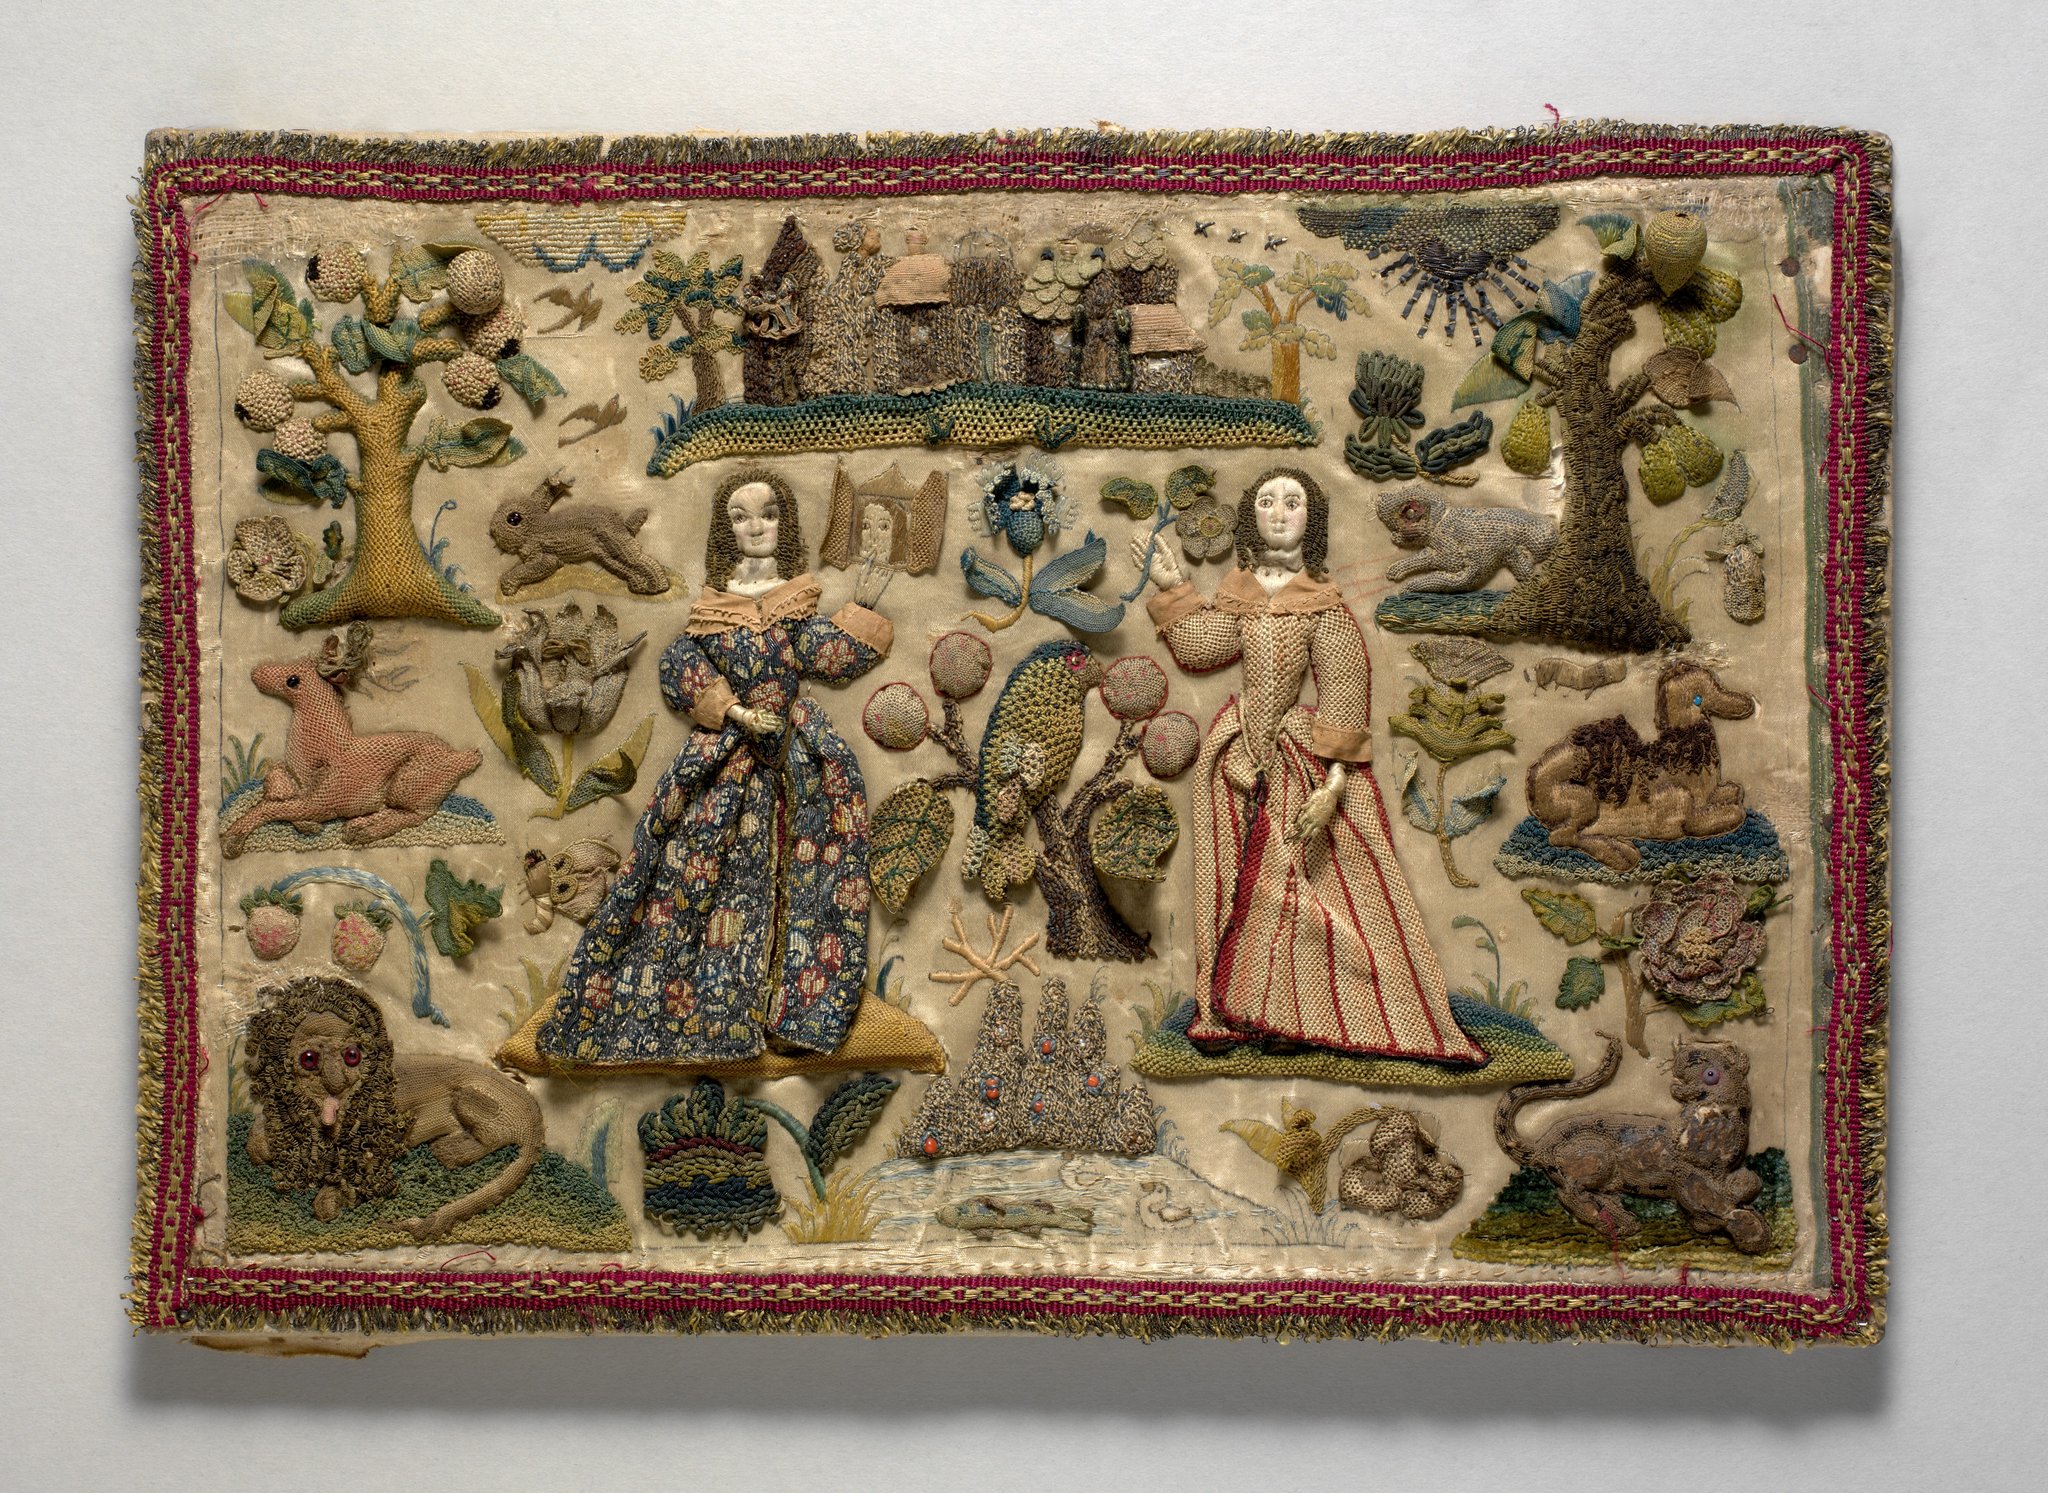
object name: embroidered picture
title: Two ladies in a landscape with a castle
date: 1651-1675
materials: metal thread, silk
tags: castles,women,deer,lions,rabbits,trees